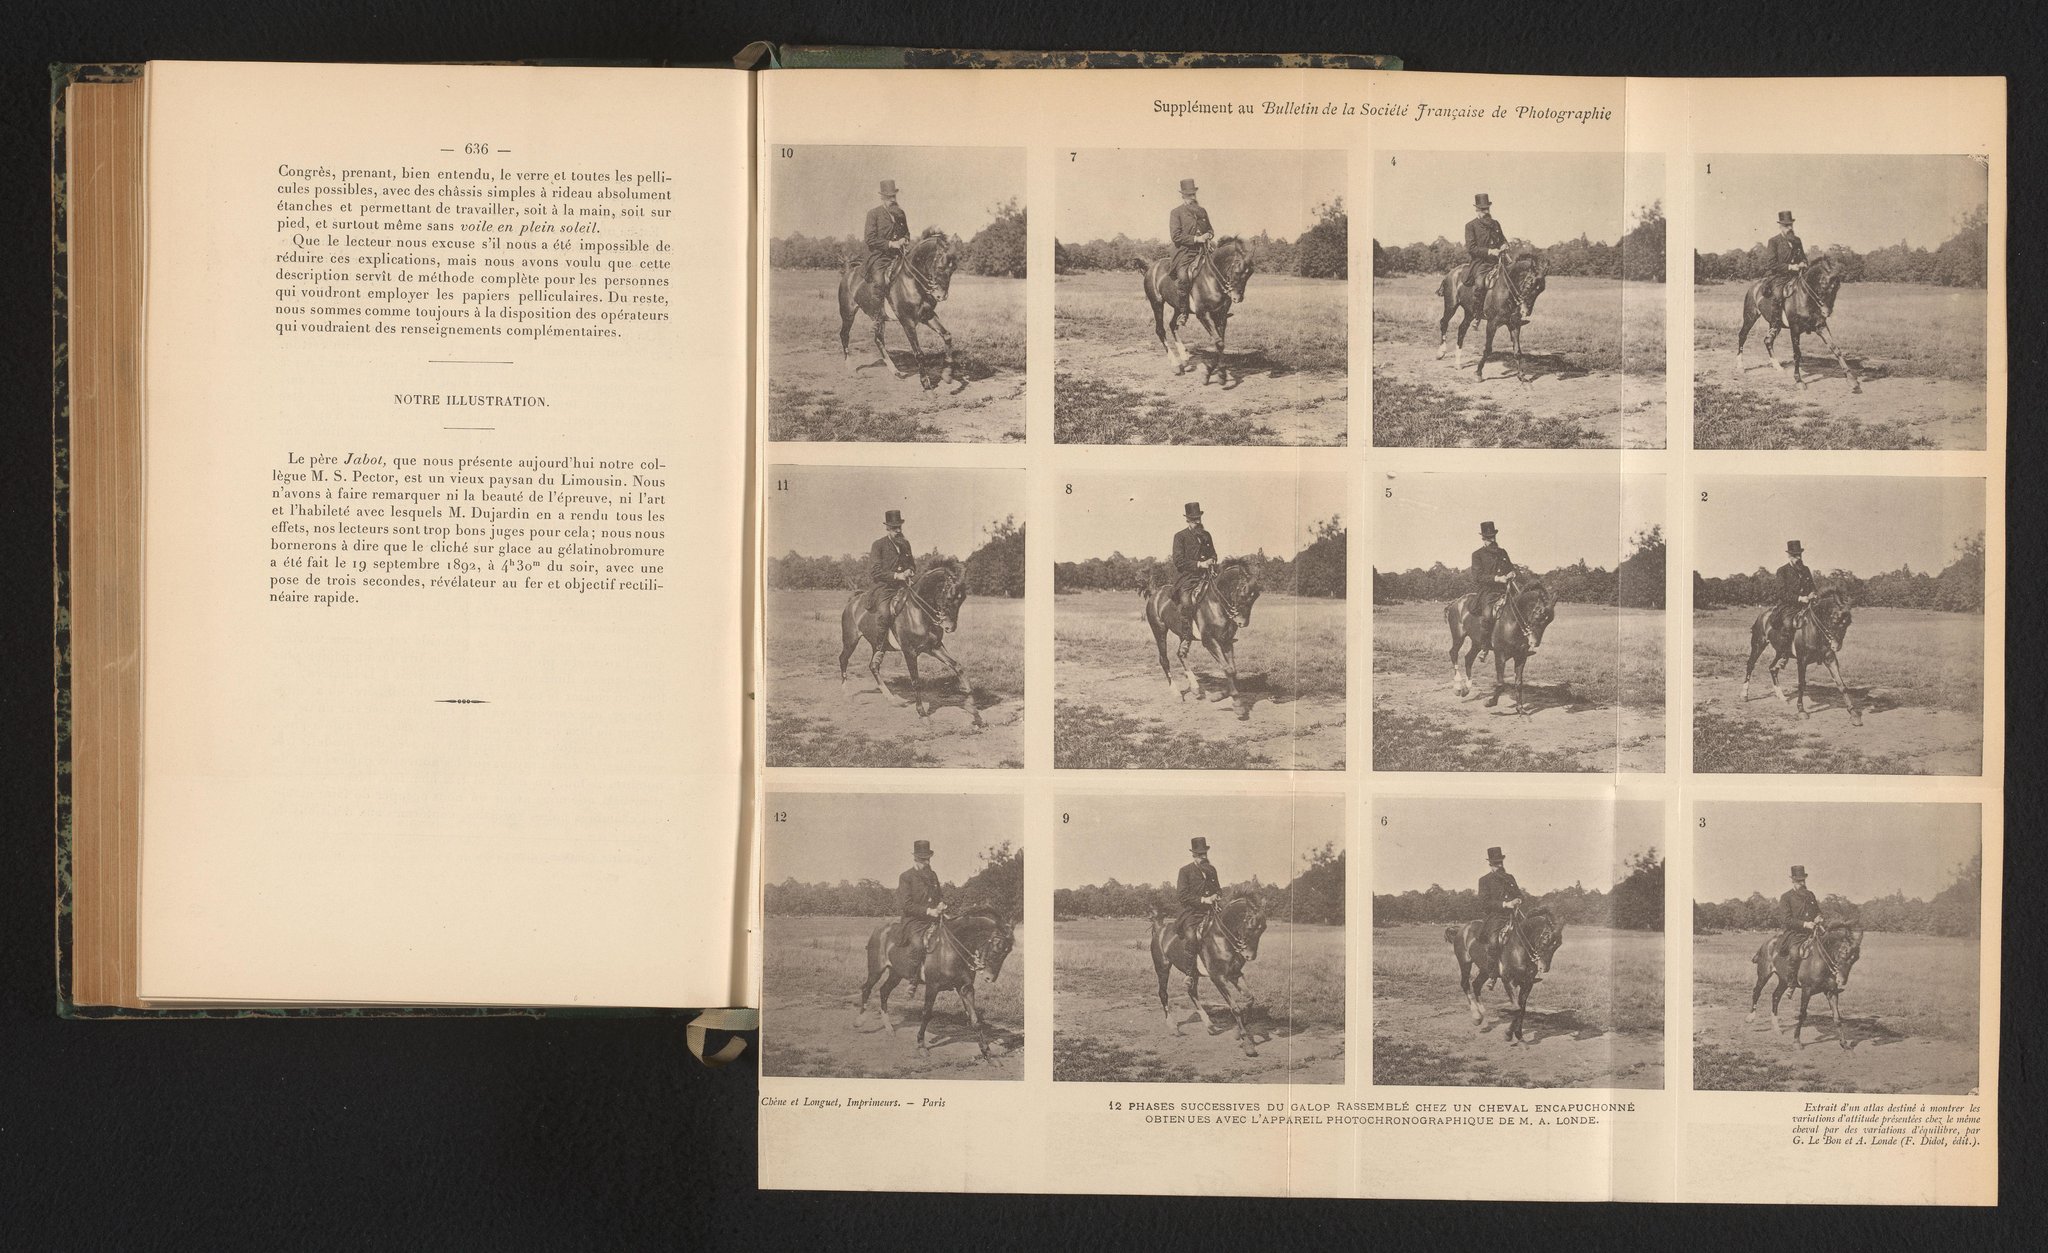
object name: page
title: Twaalf bewegingsstudies van een galopperend paard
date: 1888-1893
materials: paper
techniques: photograph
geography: paris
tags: riding a horse, ass, or mule; rider, horseman, horse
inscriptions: inscription: ‘Extrait d'un atlas destiné à montrer les/ variations d'attitude présentées chez le même/ cheval par des variations d'équilibre, par/ G. Le Bon et A. Londe (F. Didot, édit.).’